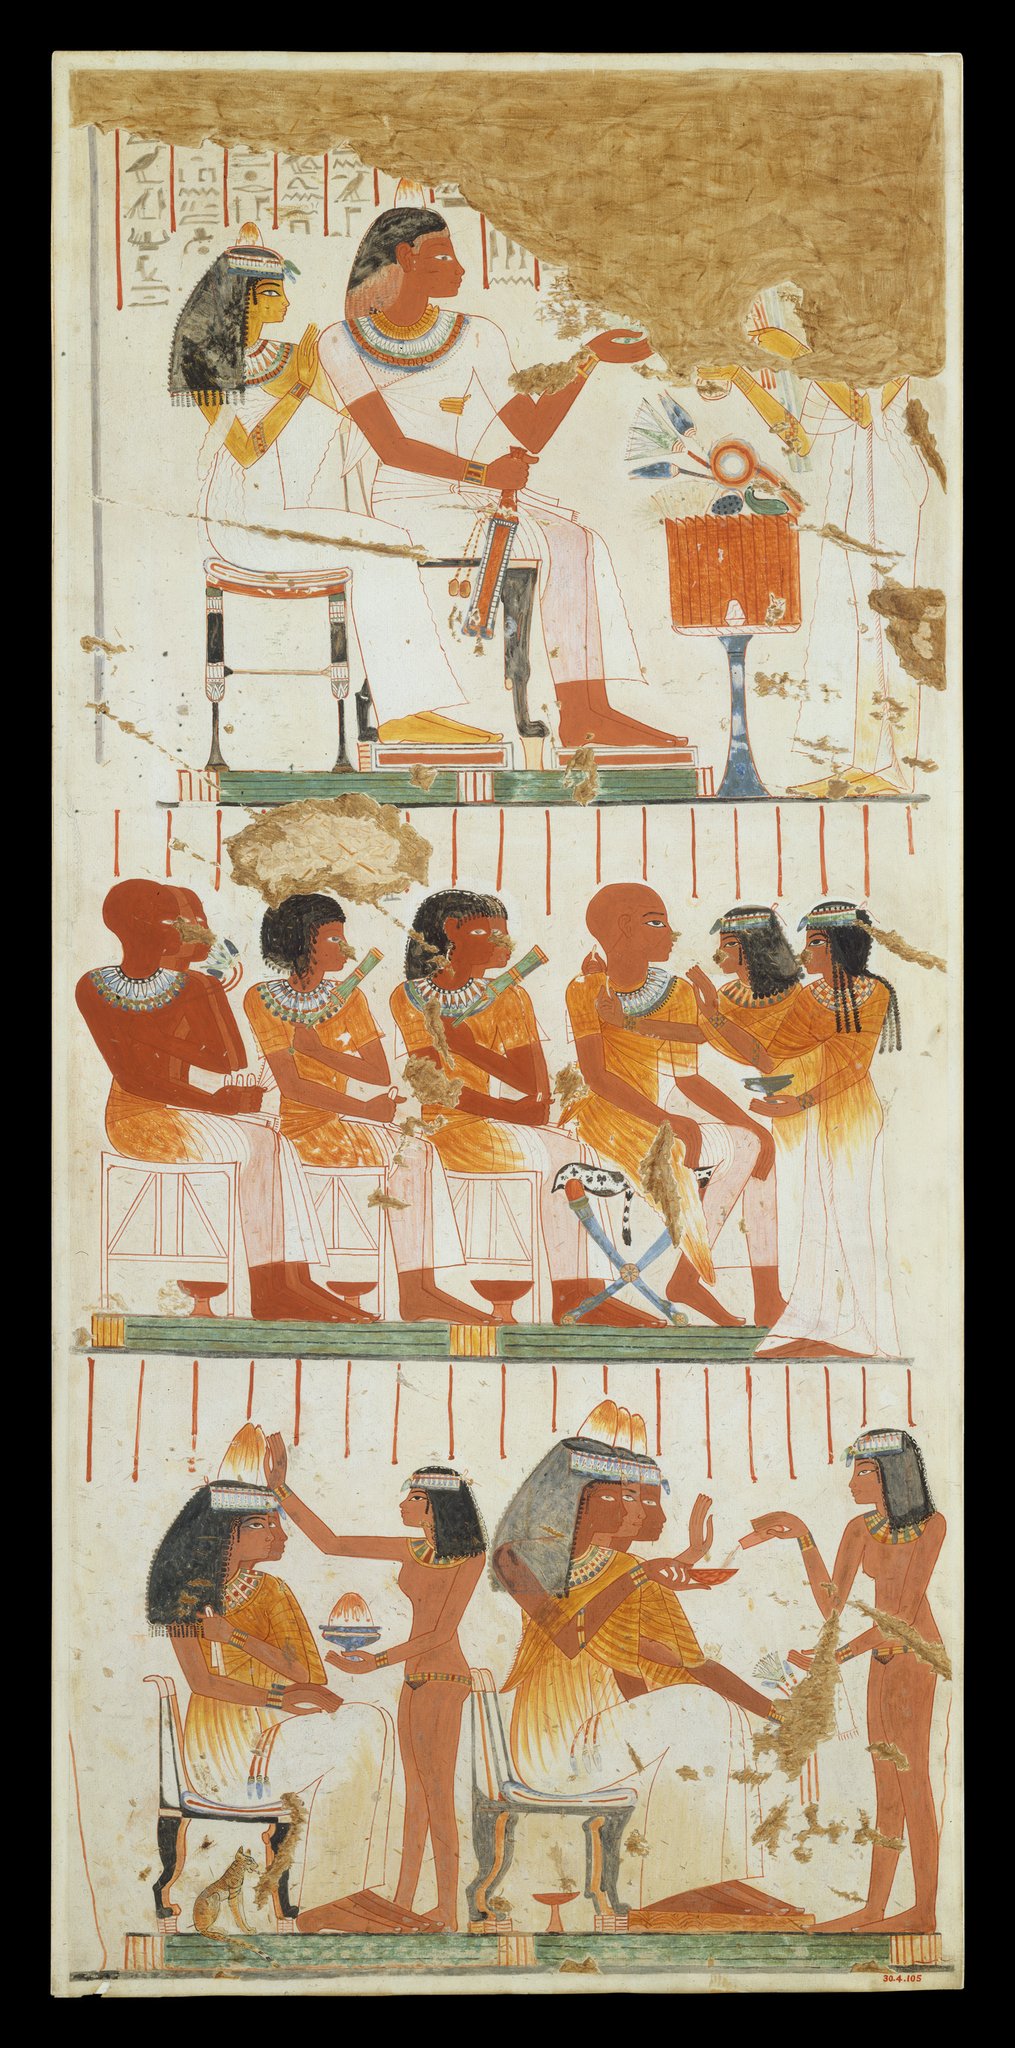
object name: facsimile, nebamun tt 181, ipuky, banquet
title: Guests at a Banquet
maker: nina de garis davies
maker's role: artist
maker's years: 1881-1965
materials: paper, paint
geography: egypt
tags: men,women,drink-and-be-merry